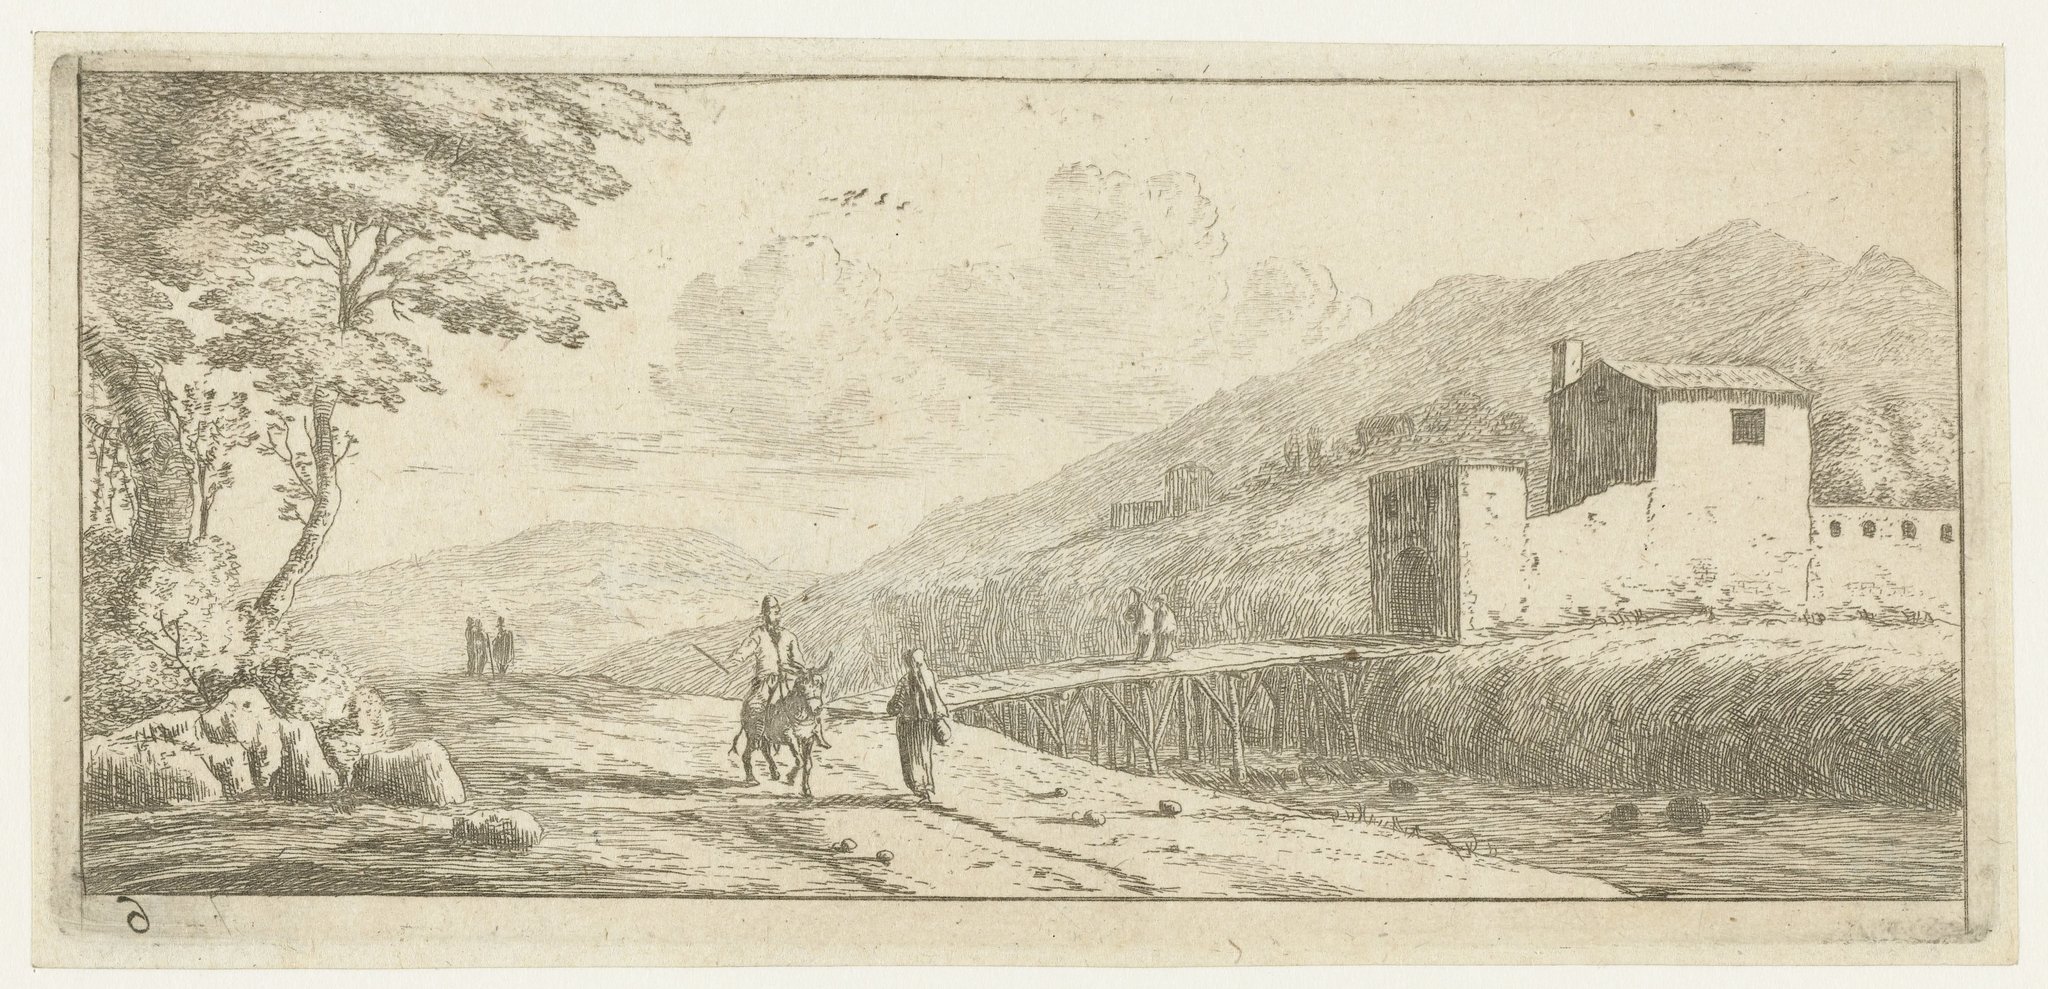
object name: print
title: Landschap met een man op een ezel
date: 1651-1652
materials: paper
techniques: etching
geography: netherlands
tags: ass, donkey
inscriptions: collector's mark: Lugt 2760, collector's mark: ‘twee inelkaar grijpend C's’ Lugt 505(?), collector's mark: Lugt 2228, collector's mark: Lugt 567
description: Heuvelig landschap met een man rijdend op een ezel lang een rivier. Een brug bij gebouw op de oever.